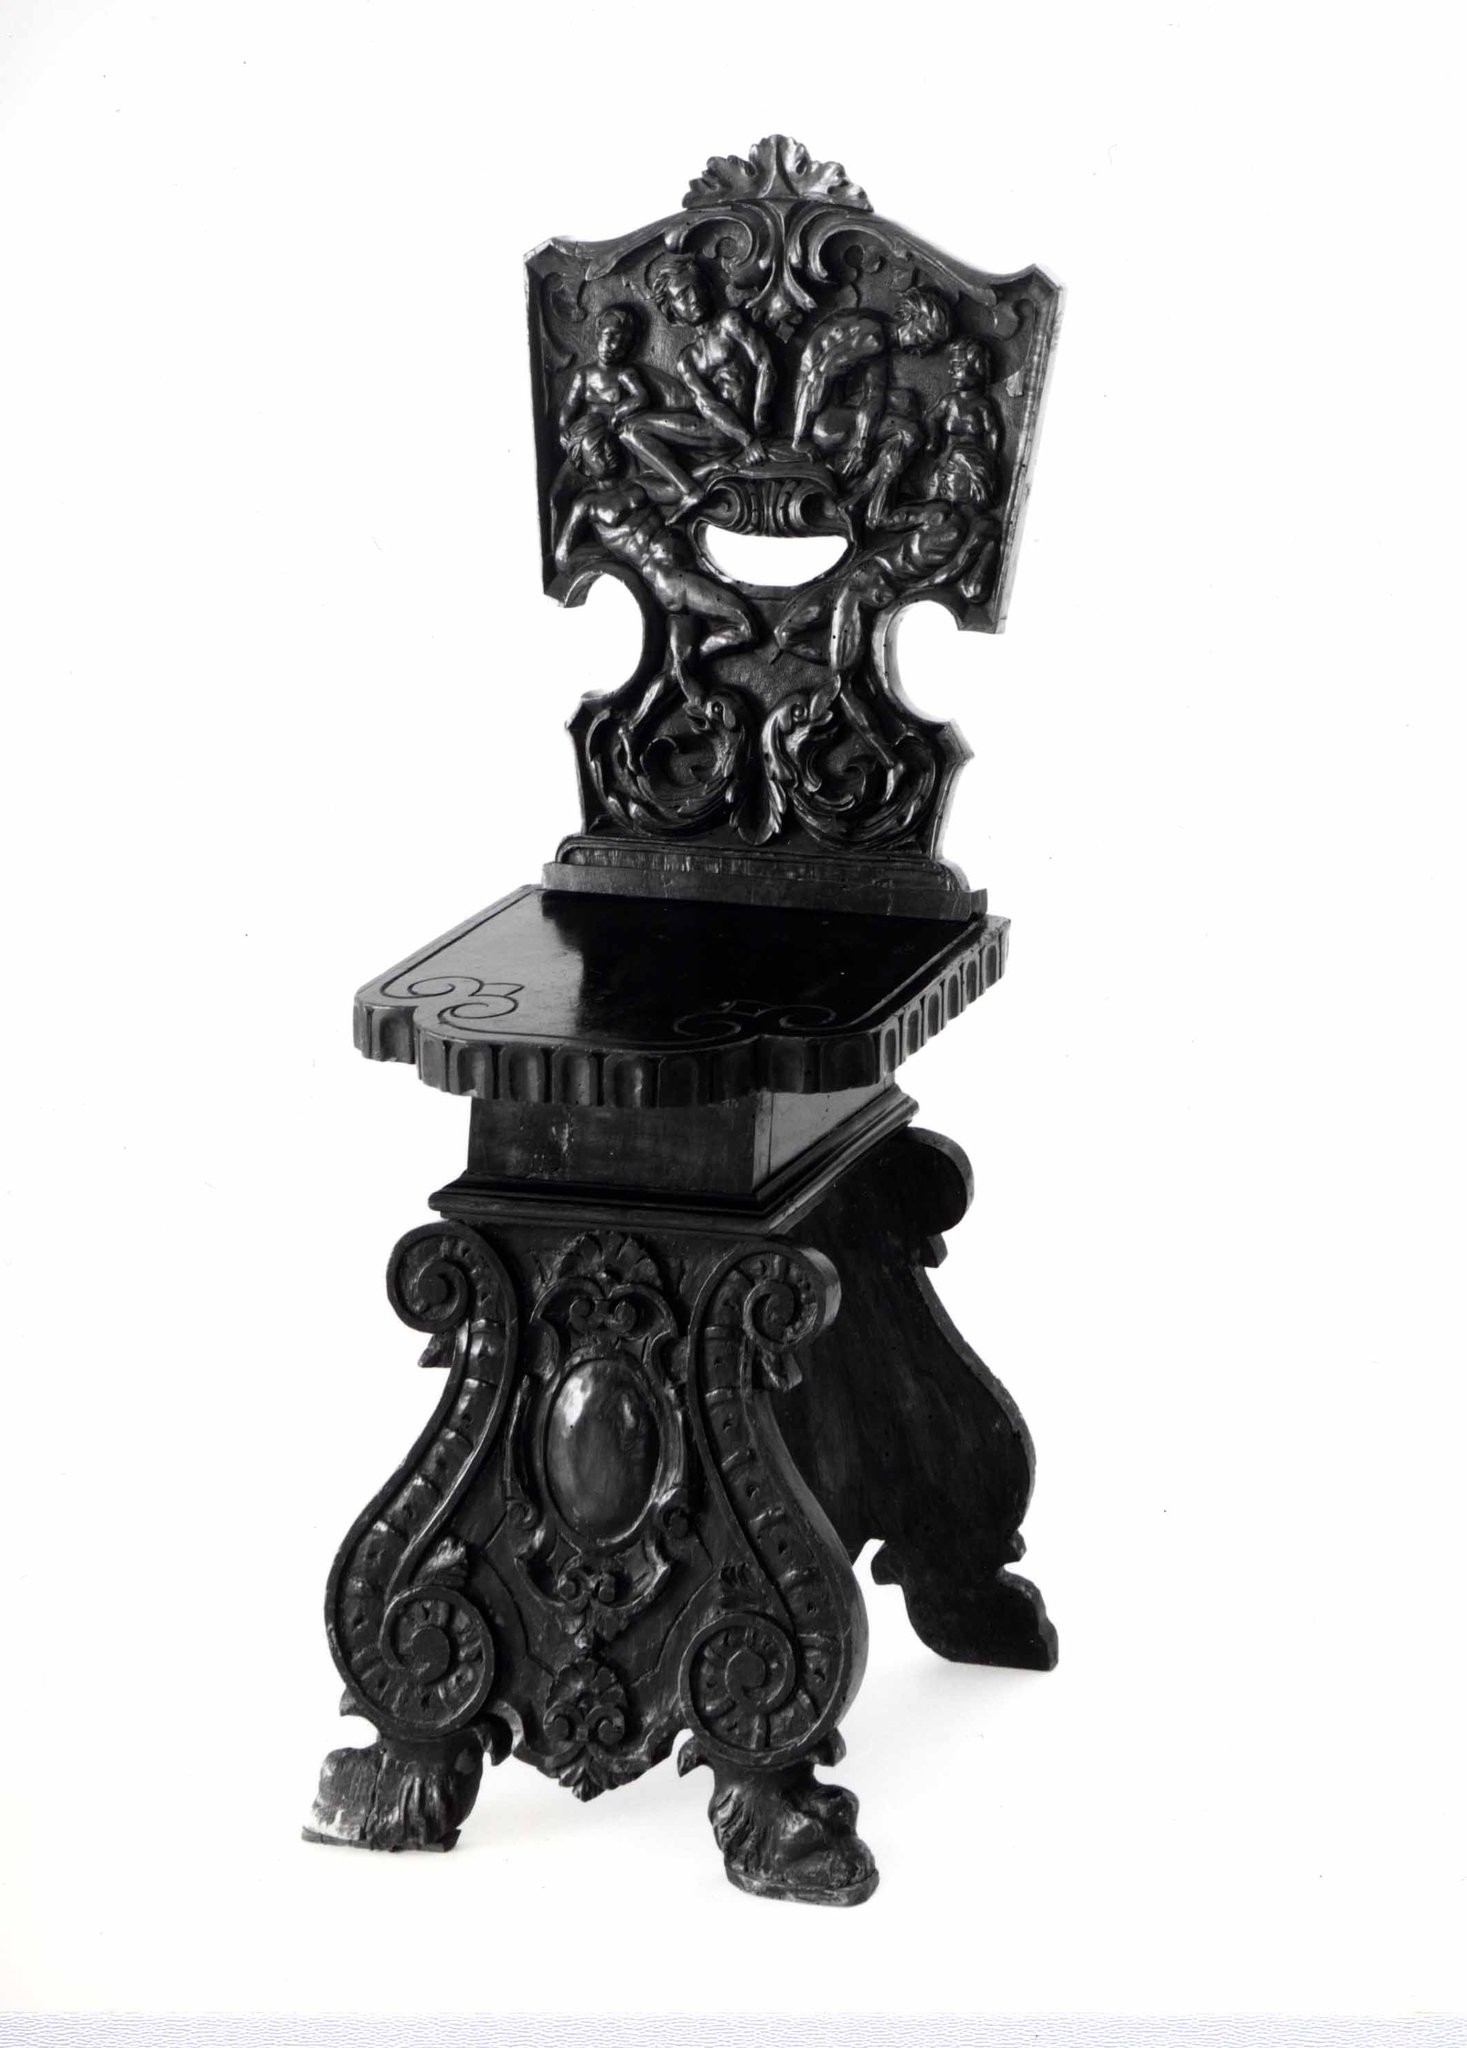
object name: chair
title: Side chair (sgabello, pair with 1975.1.2037)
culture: italian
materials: wood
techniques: carving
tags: male nudes